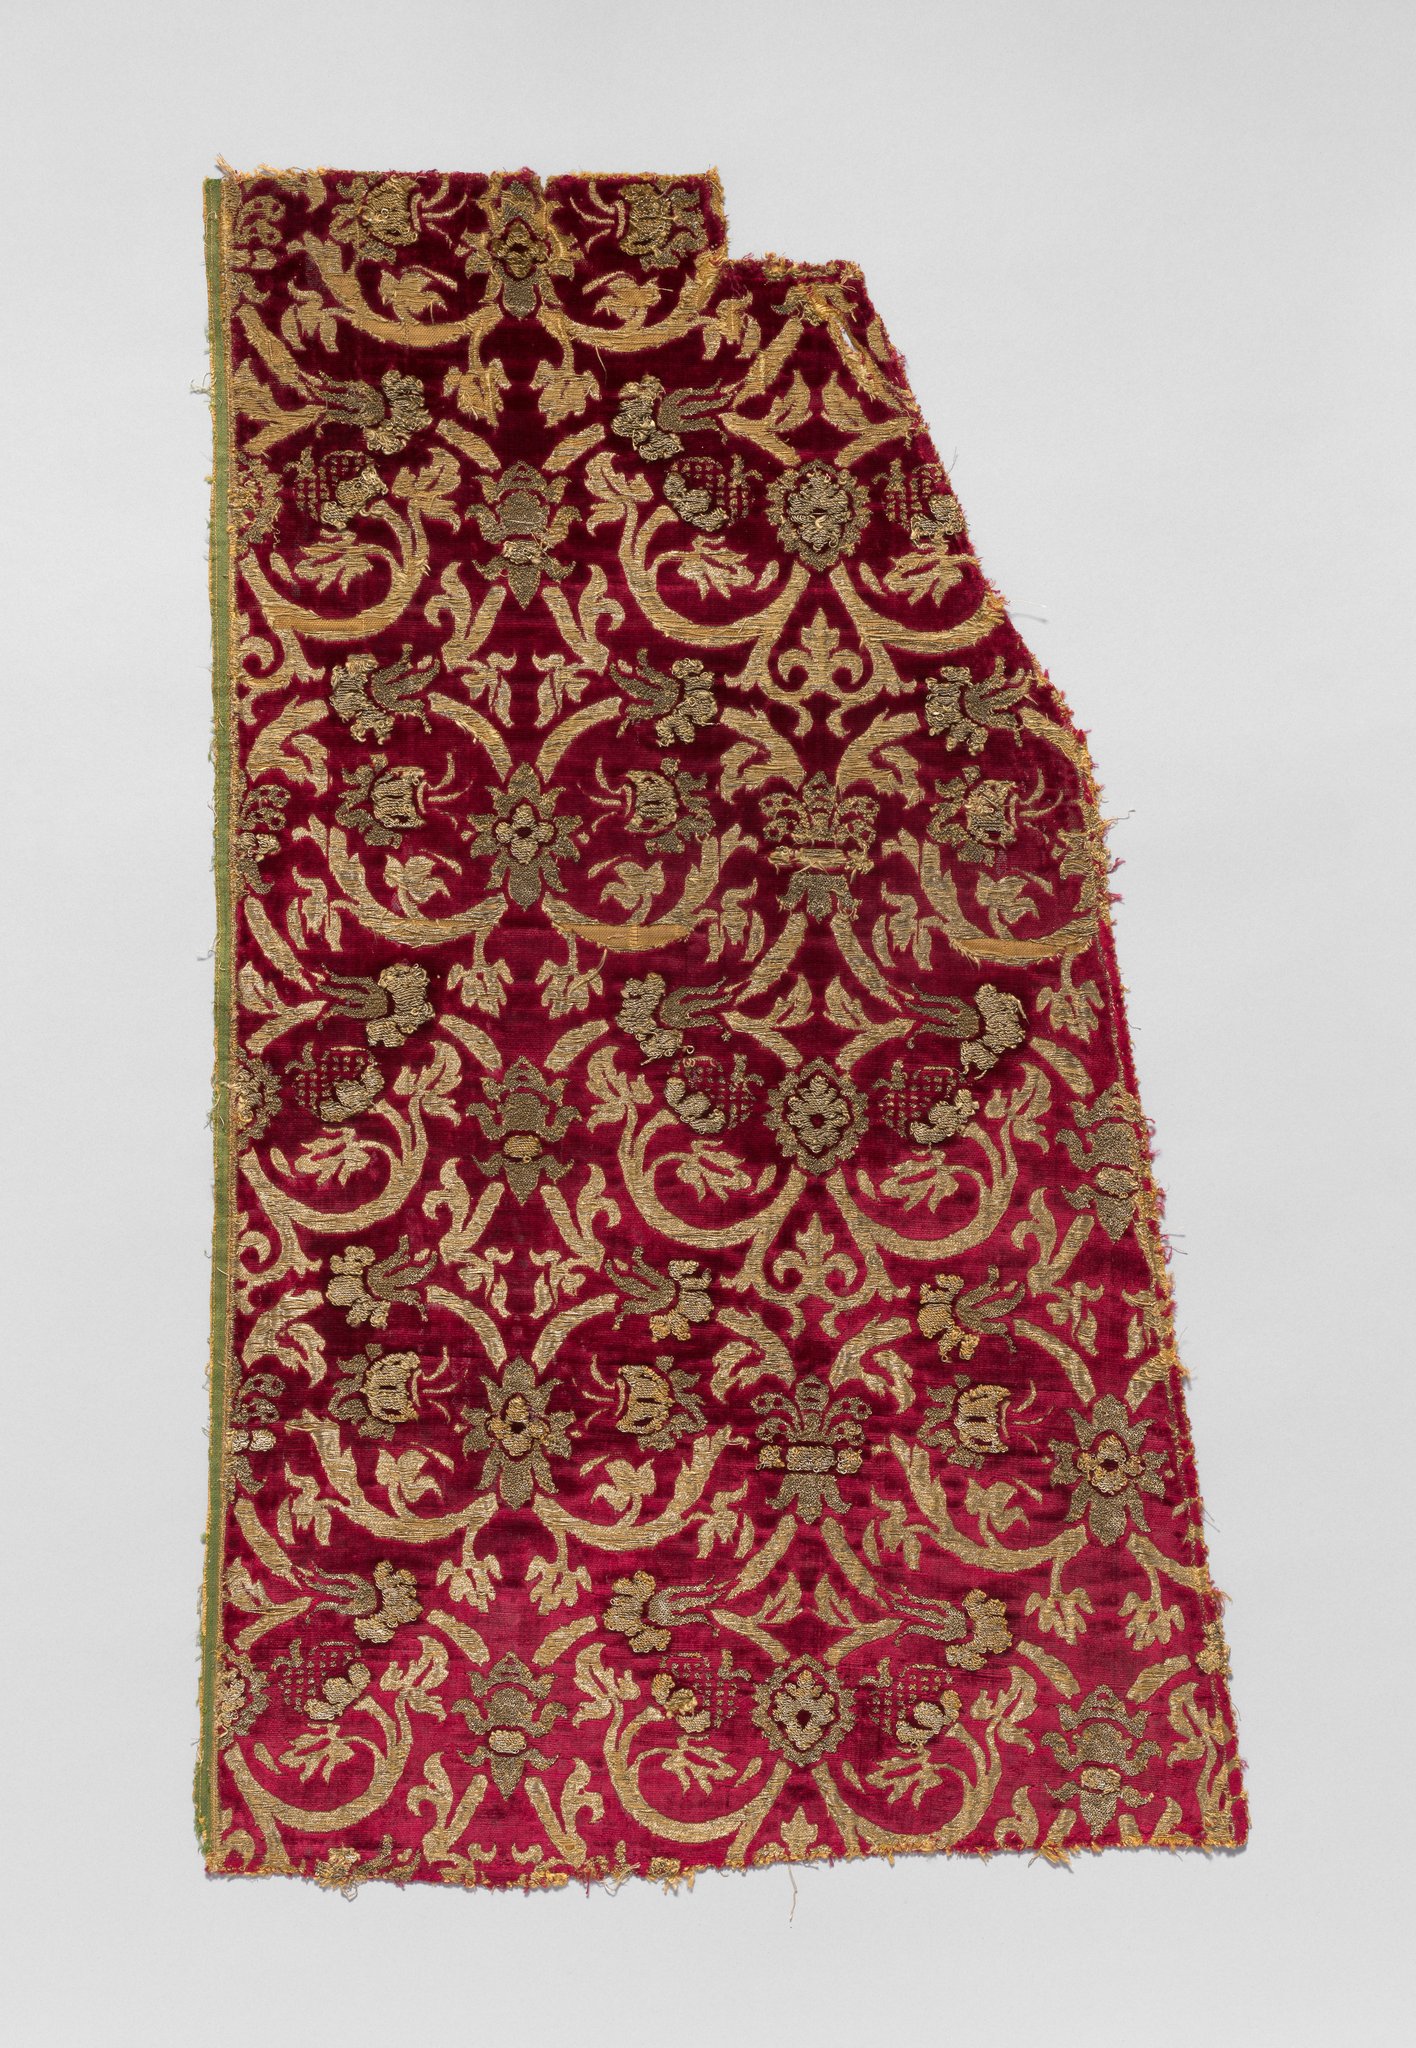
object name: panel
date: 1467-1533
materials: metal thread, silk